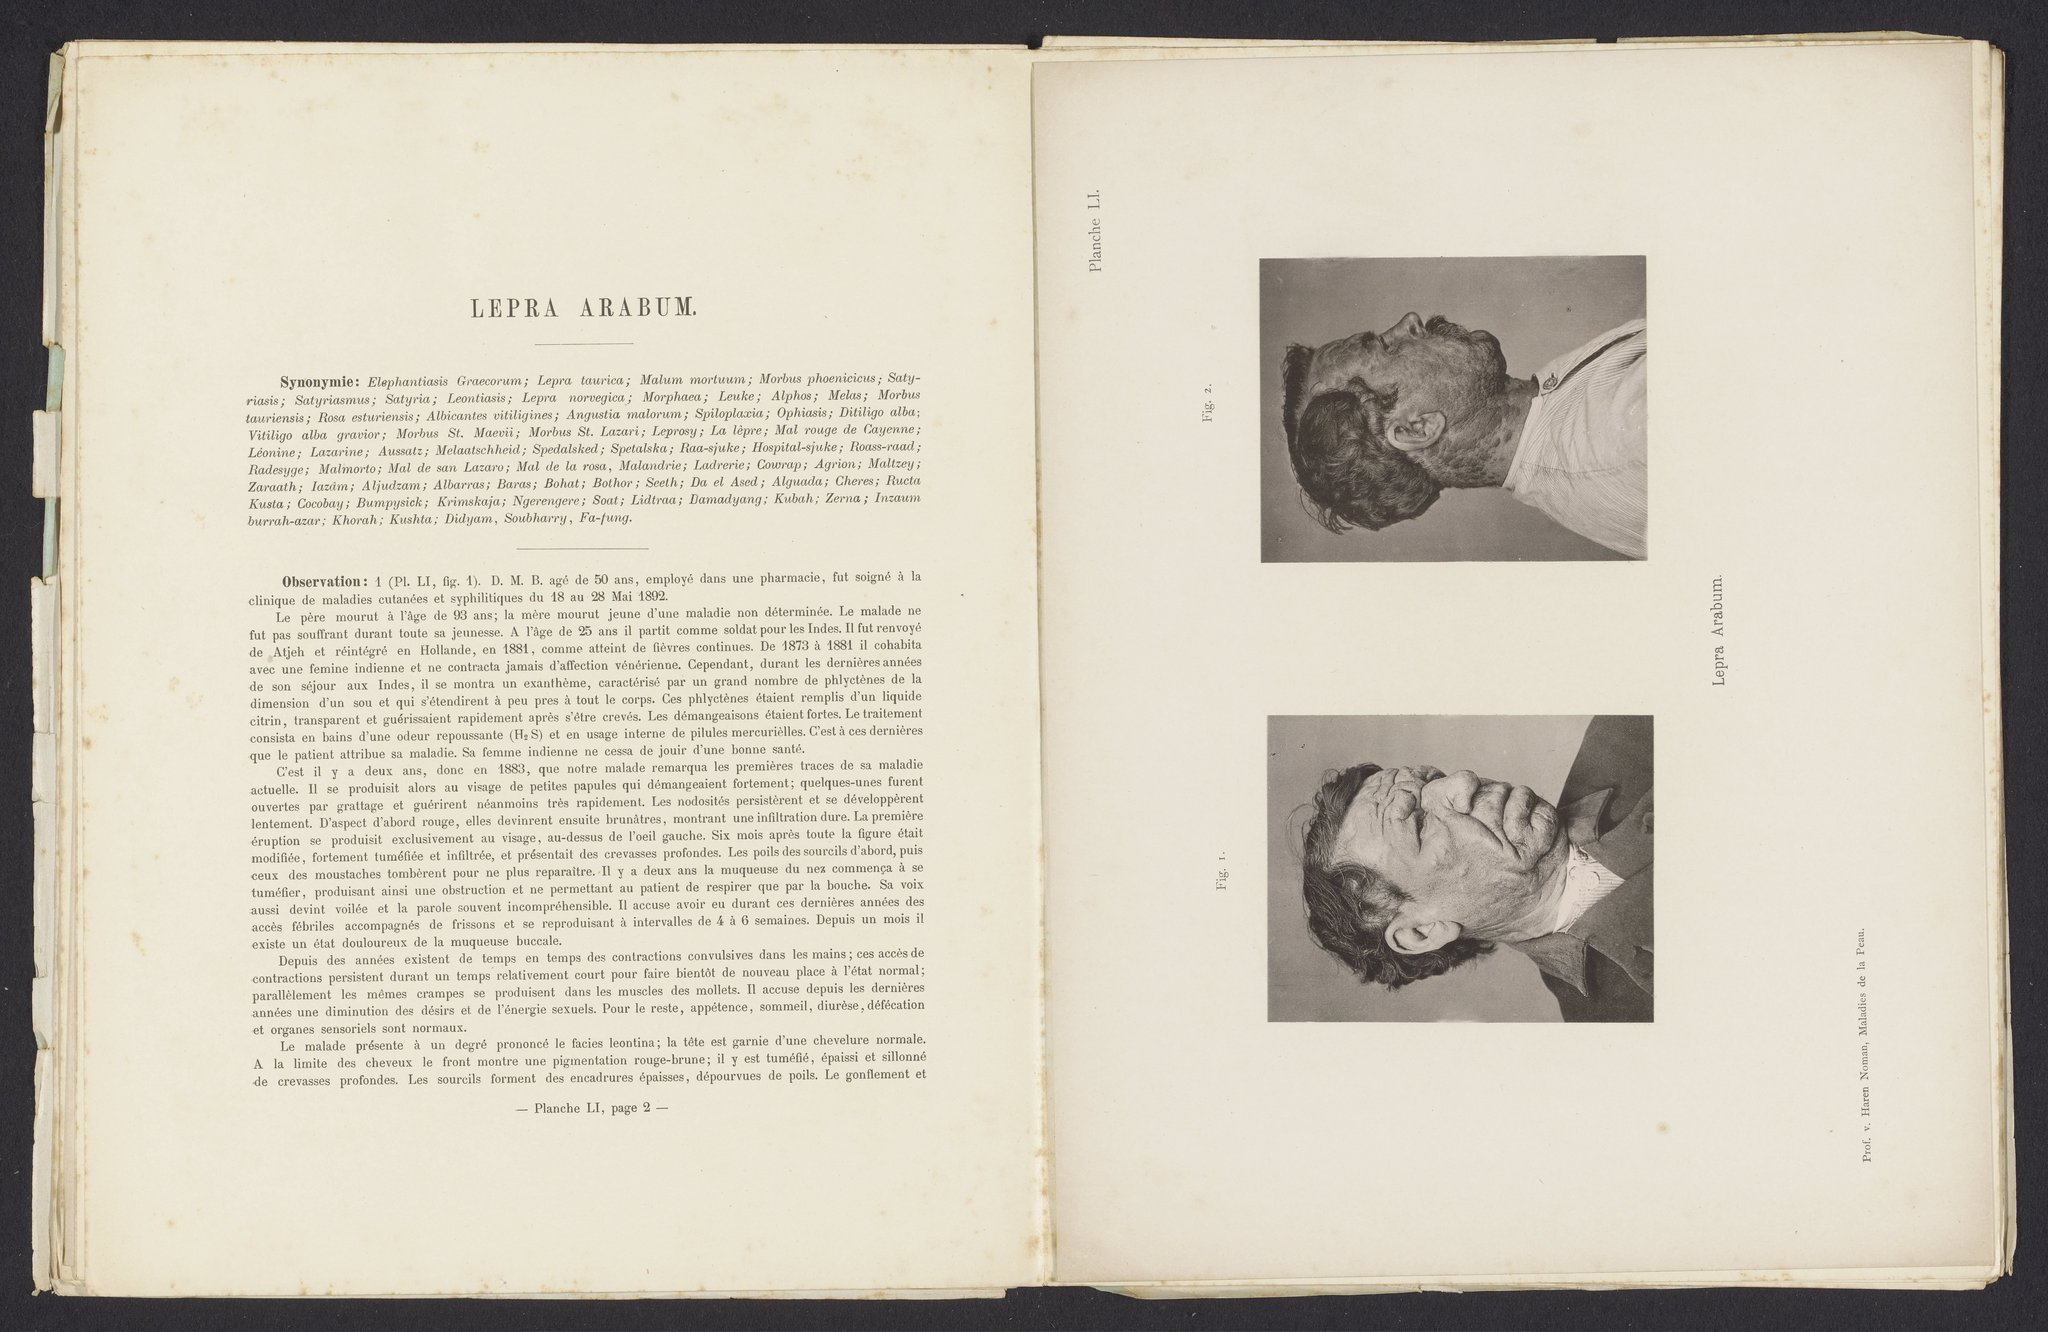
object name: page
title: Lepra Arabum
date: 1885-1895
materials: paper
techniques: photograph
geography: amsterdam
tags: face, head (human), skin and venereal diseases, adult man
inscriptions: number: ‘Planche LI. / Fig. 1. / Fig. 2’